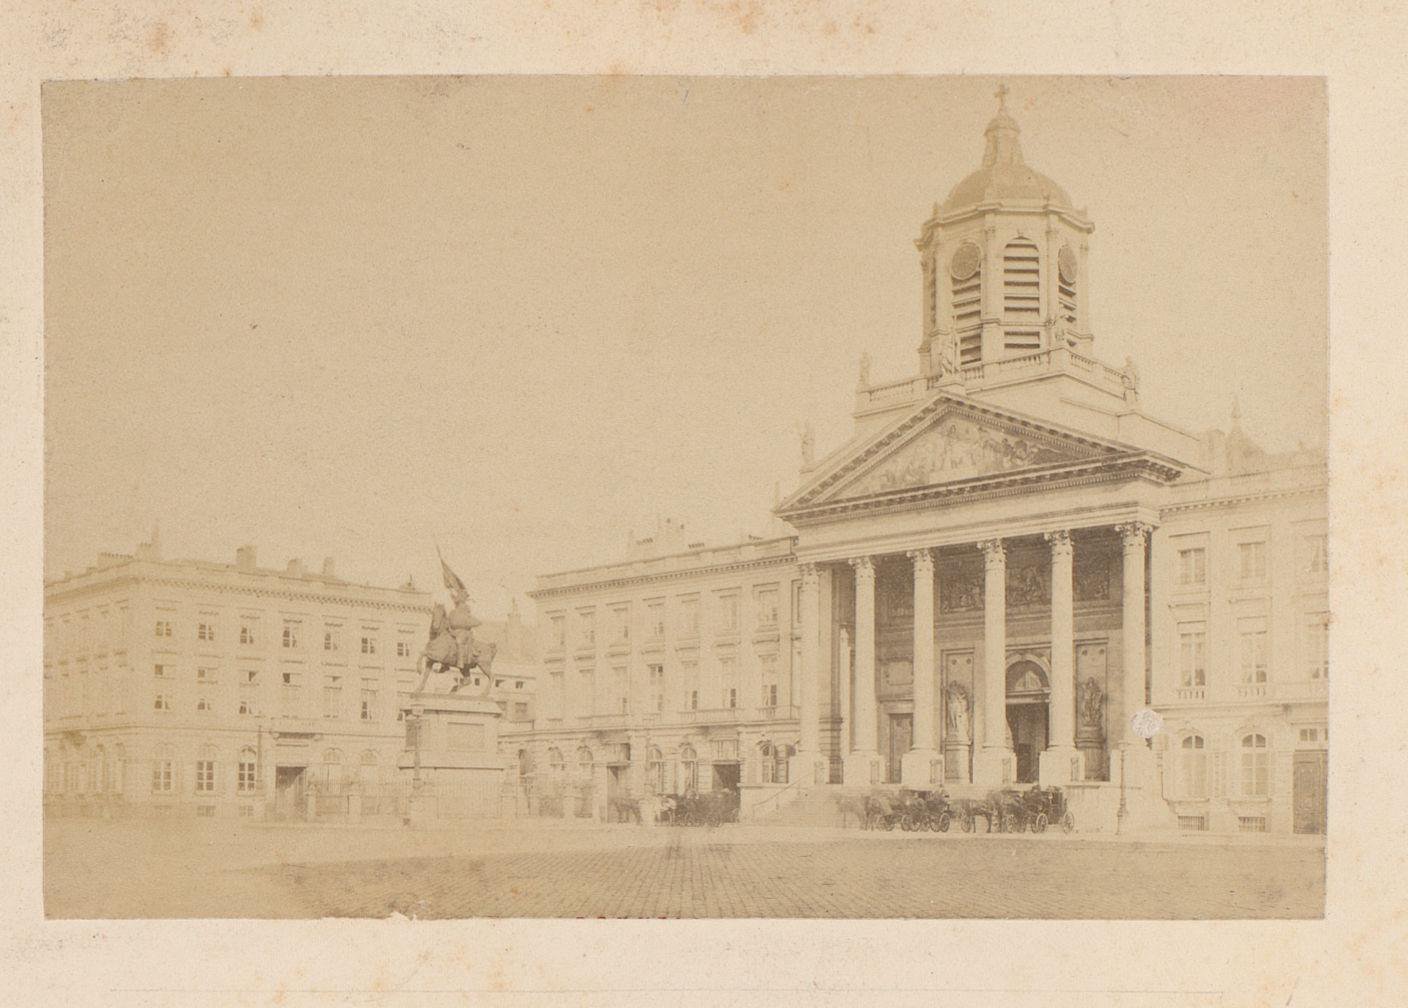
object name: photograph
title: Gezicht op het Koningsplein en het standbeeld van Godfried van Bouillon te Brussel, België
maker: Anonymous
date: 1860-1890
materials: paper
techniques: albumen print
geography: brussels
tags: godfrey of bouillon, square, place, circus, etc., church (exterior), monument, statue